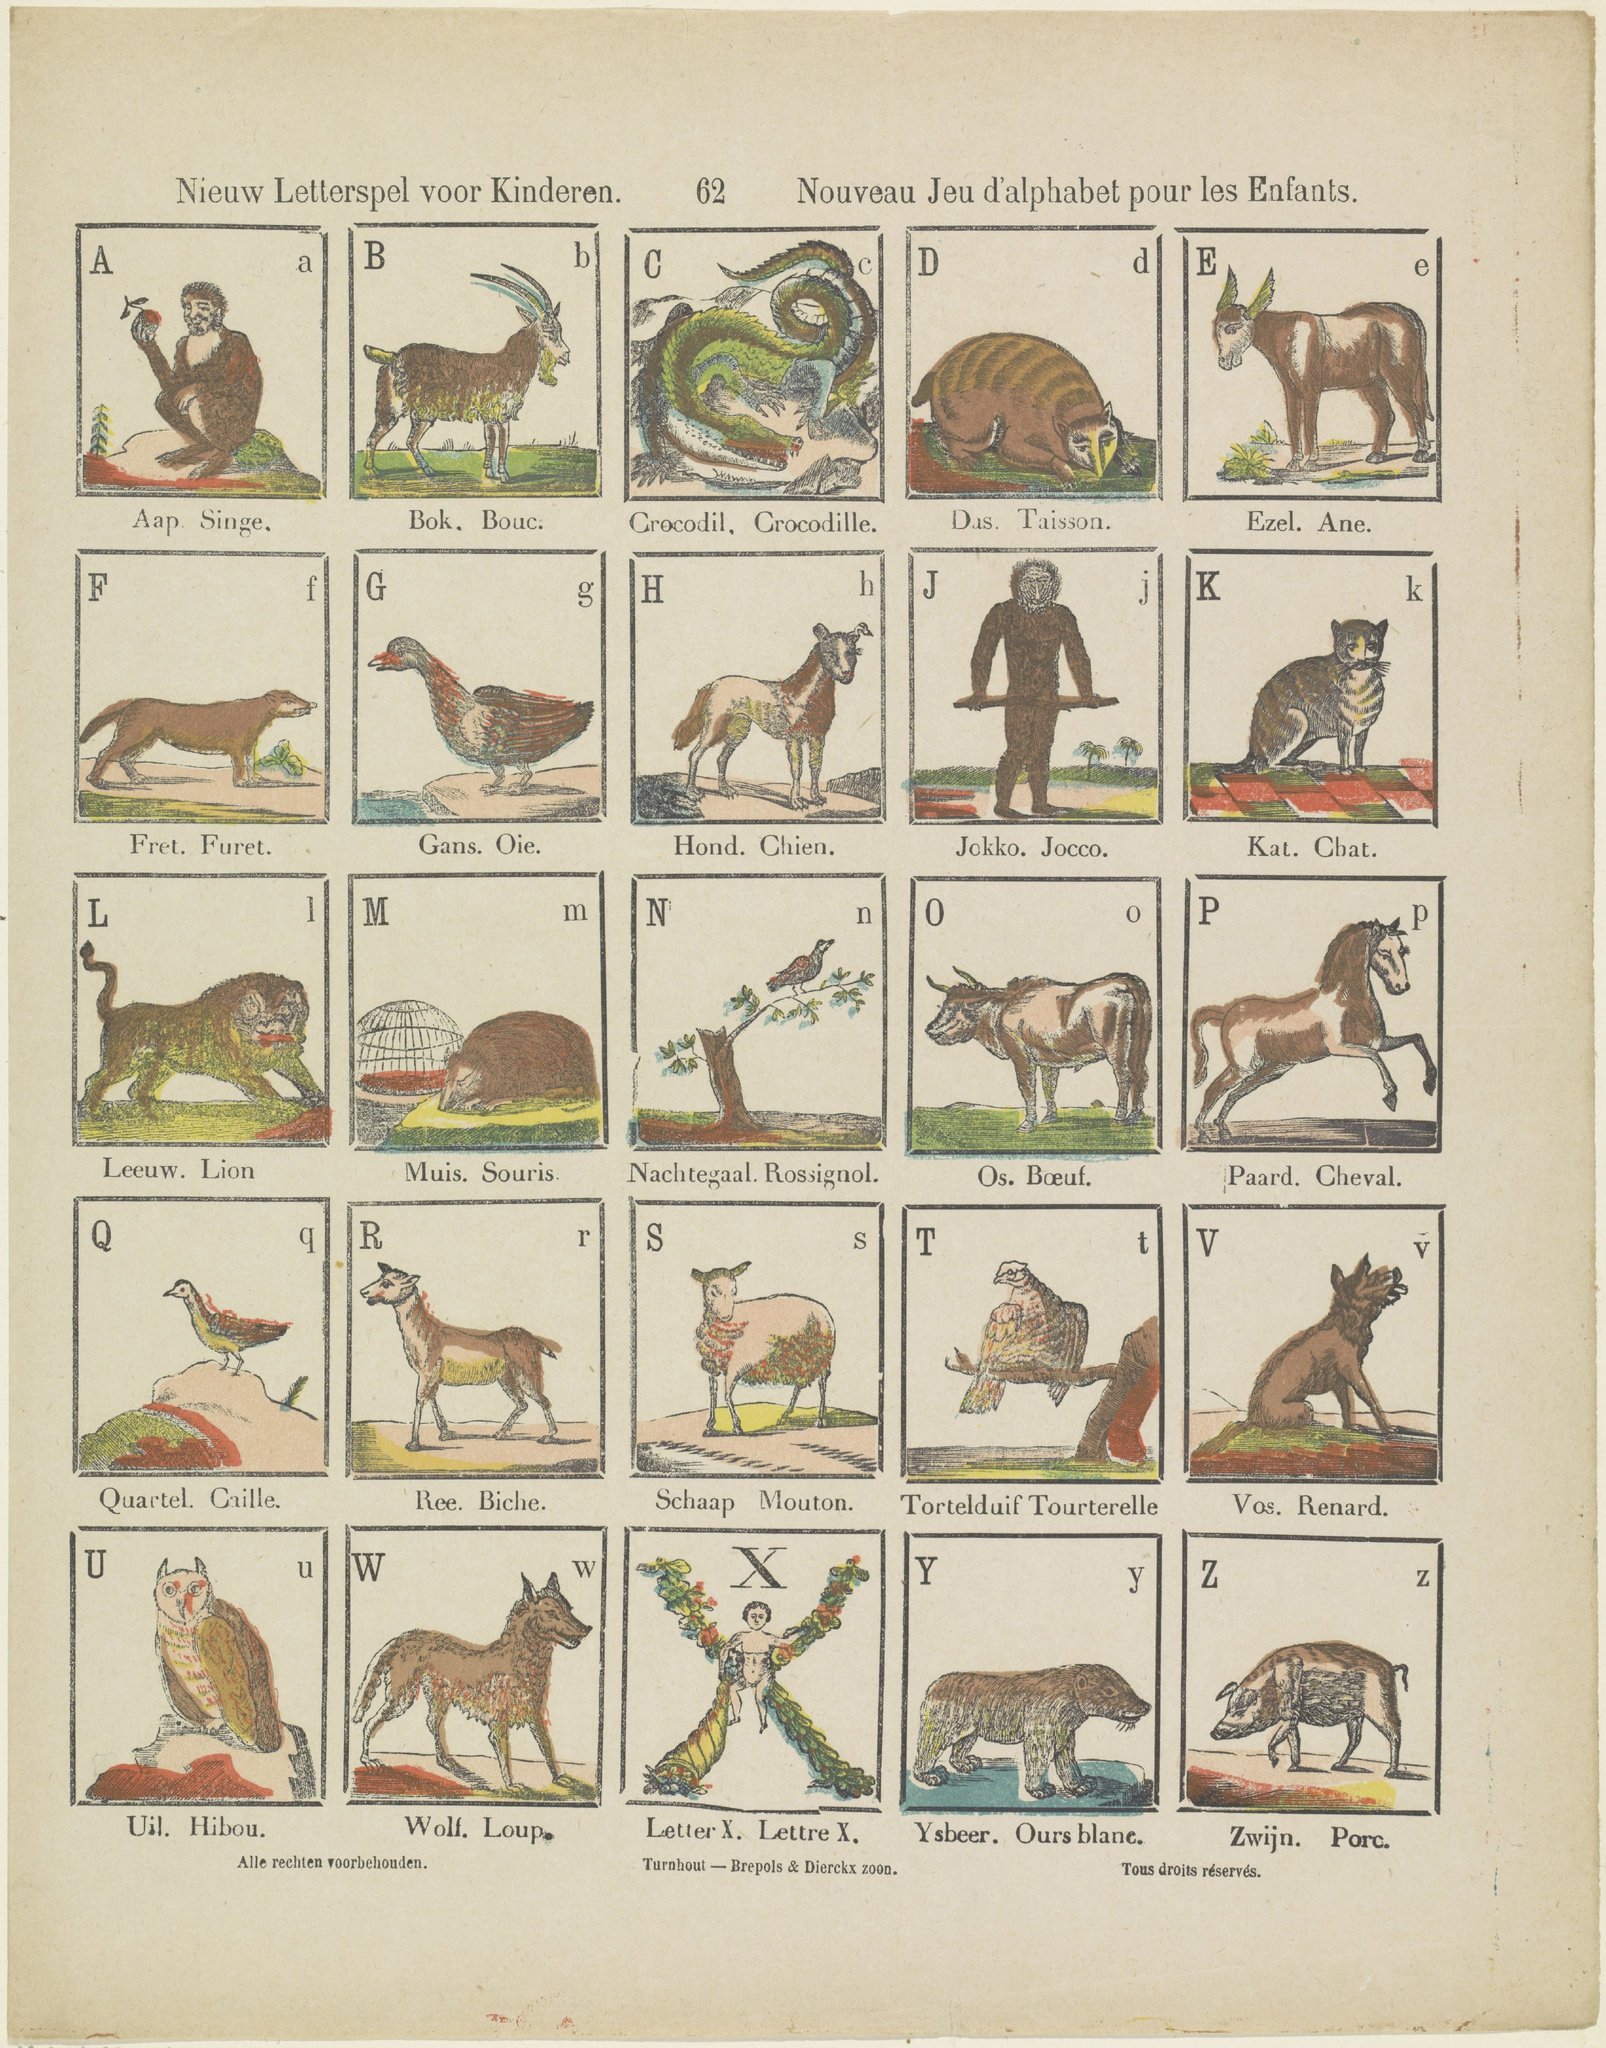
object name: print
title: Nieuw letterspel voor kinderen / Nouveau jeu d'alphabet pour les enfants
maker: Anonymous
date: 1833-1911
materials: paper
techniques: lithograph, letterpress printing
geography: turnhout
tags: animals, letters, alphabet, script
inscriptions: collector's mark: Lugt 2760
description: Blad met 25 voorstellingen van de letters van het alfabet geïllustreerd met dieren waarvan de woorden met de betreffende letter beginnen. Onder elke afbeelding een onderschrift. Genummerd middenboven: 62.